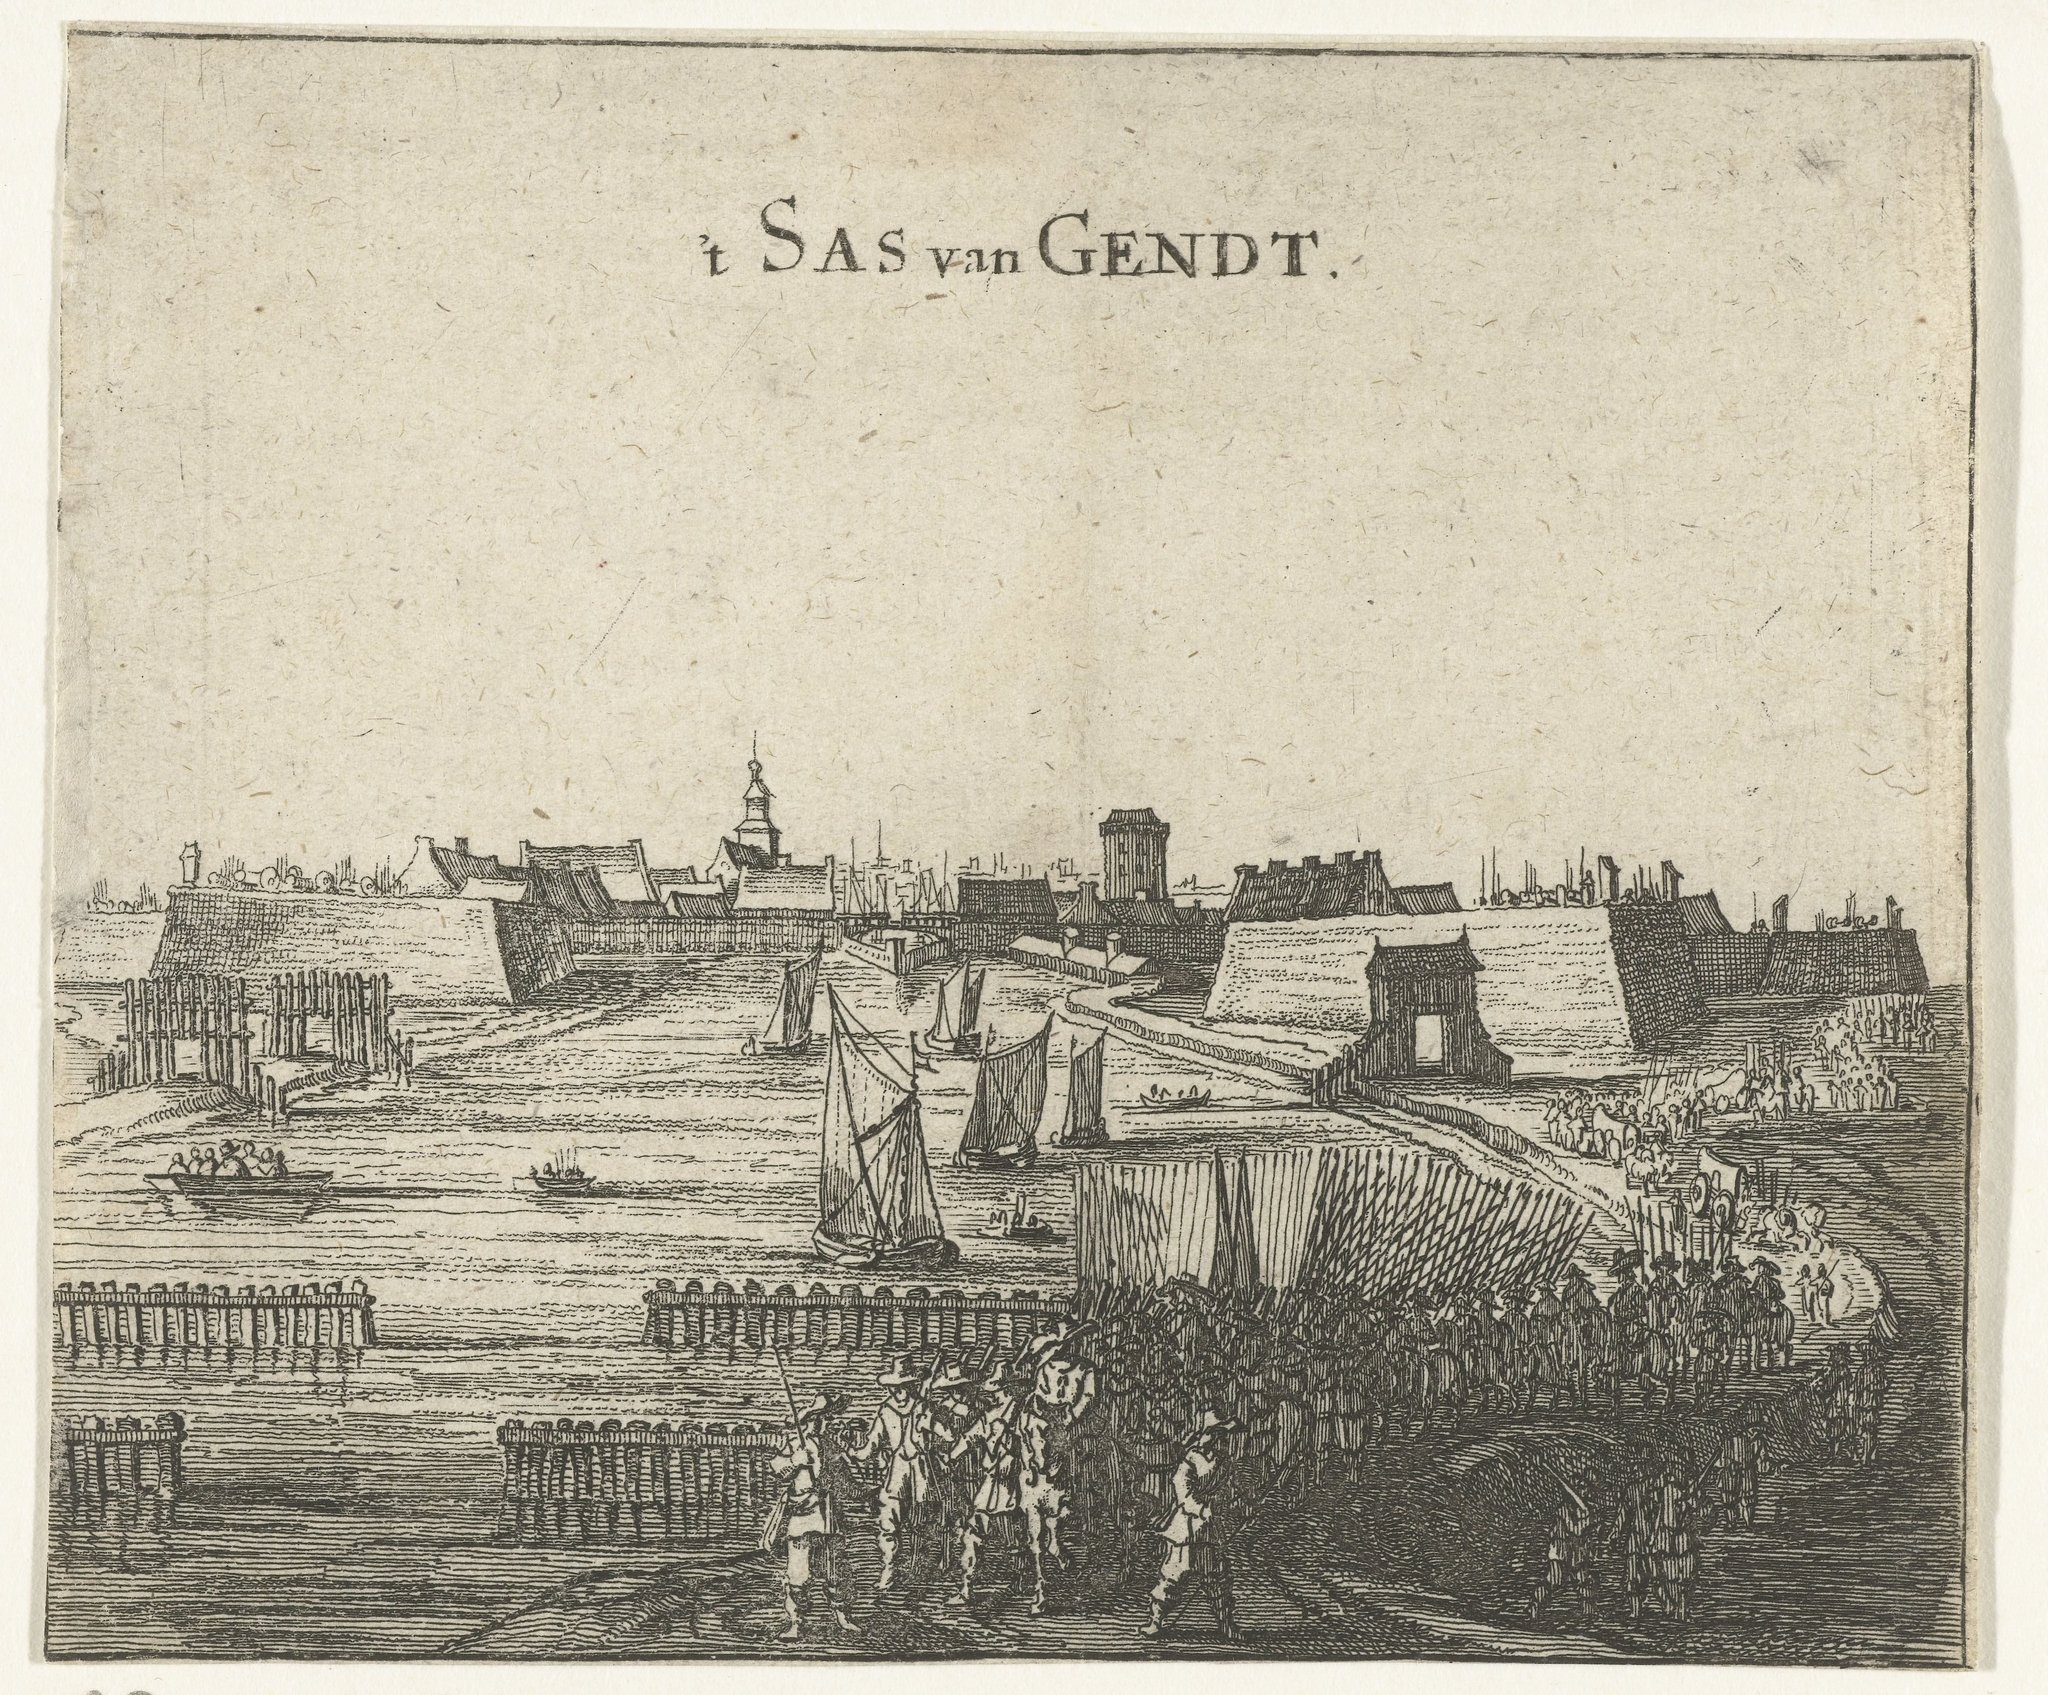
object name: print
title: 't Sas van Gendt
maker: Anonymous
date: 1650-1652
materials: paper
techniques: etching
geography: northern netherlands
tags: delft, the hague, frederick henry (prince of orange), siege, position war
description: Beleg en inname van Sas-van-Gent door het Staatse leger onder Frederik Hendrik, 28 juli tot 5 september 1644. Gezicht op de versterkte stad met op de voorgrond het optrekkende Staatse leger. Het paginanummer 525 weggepolijst.